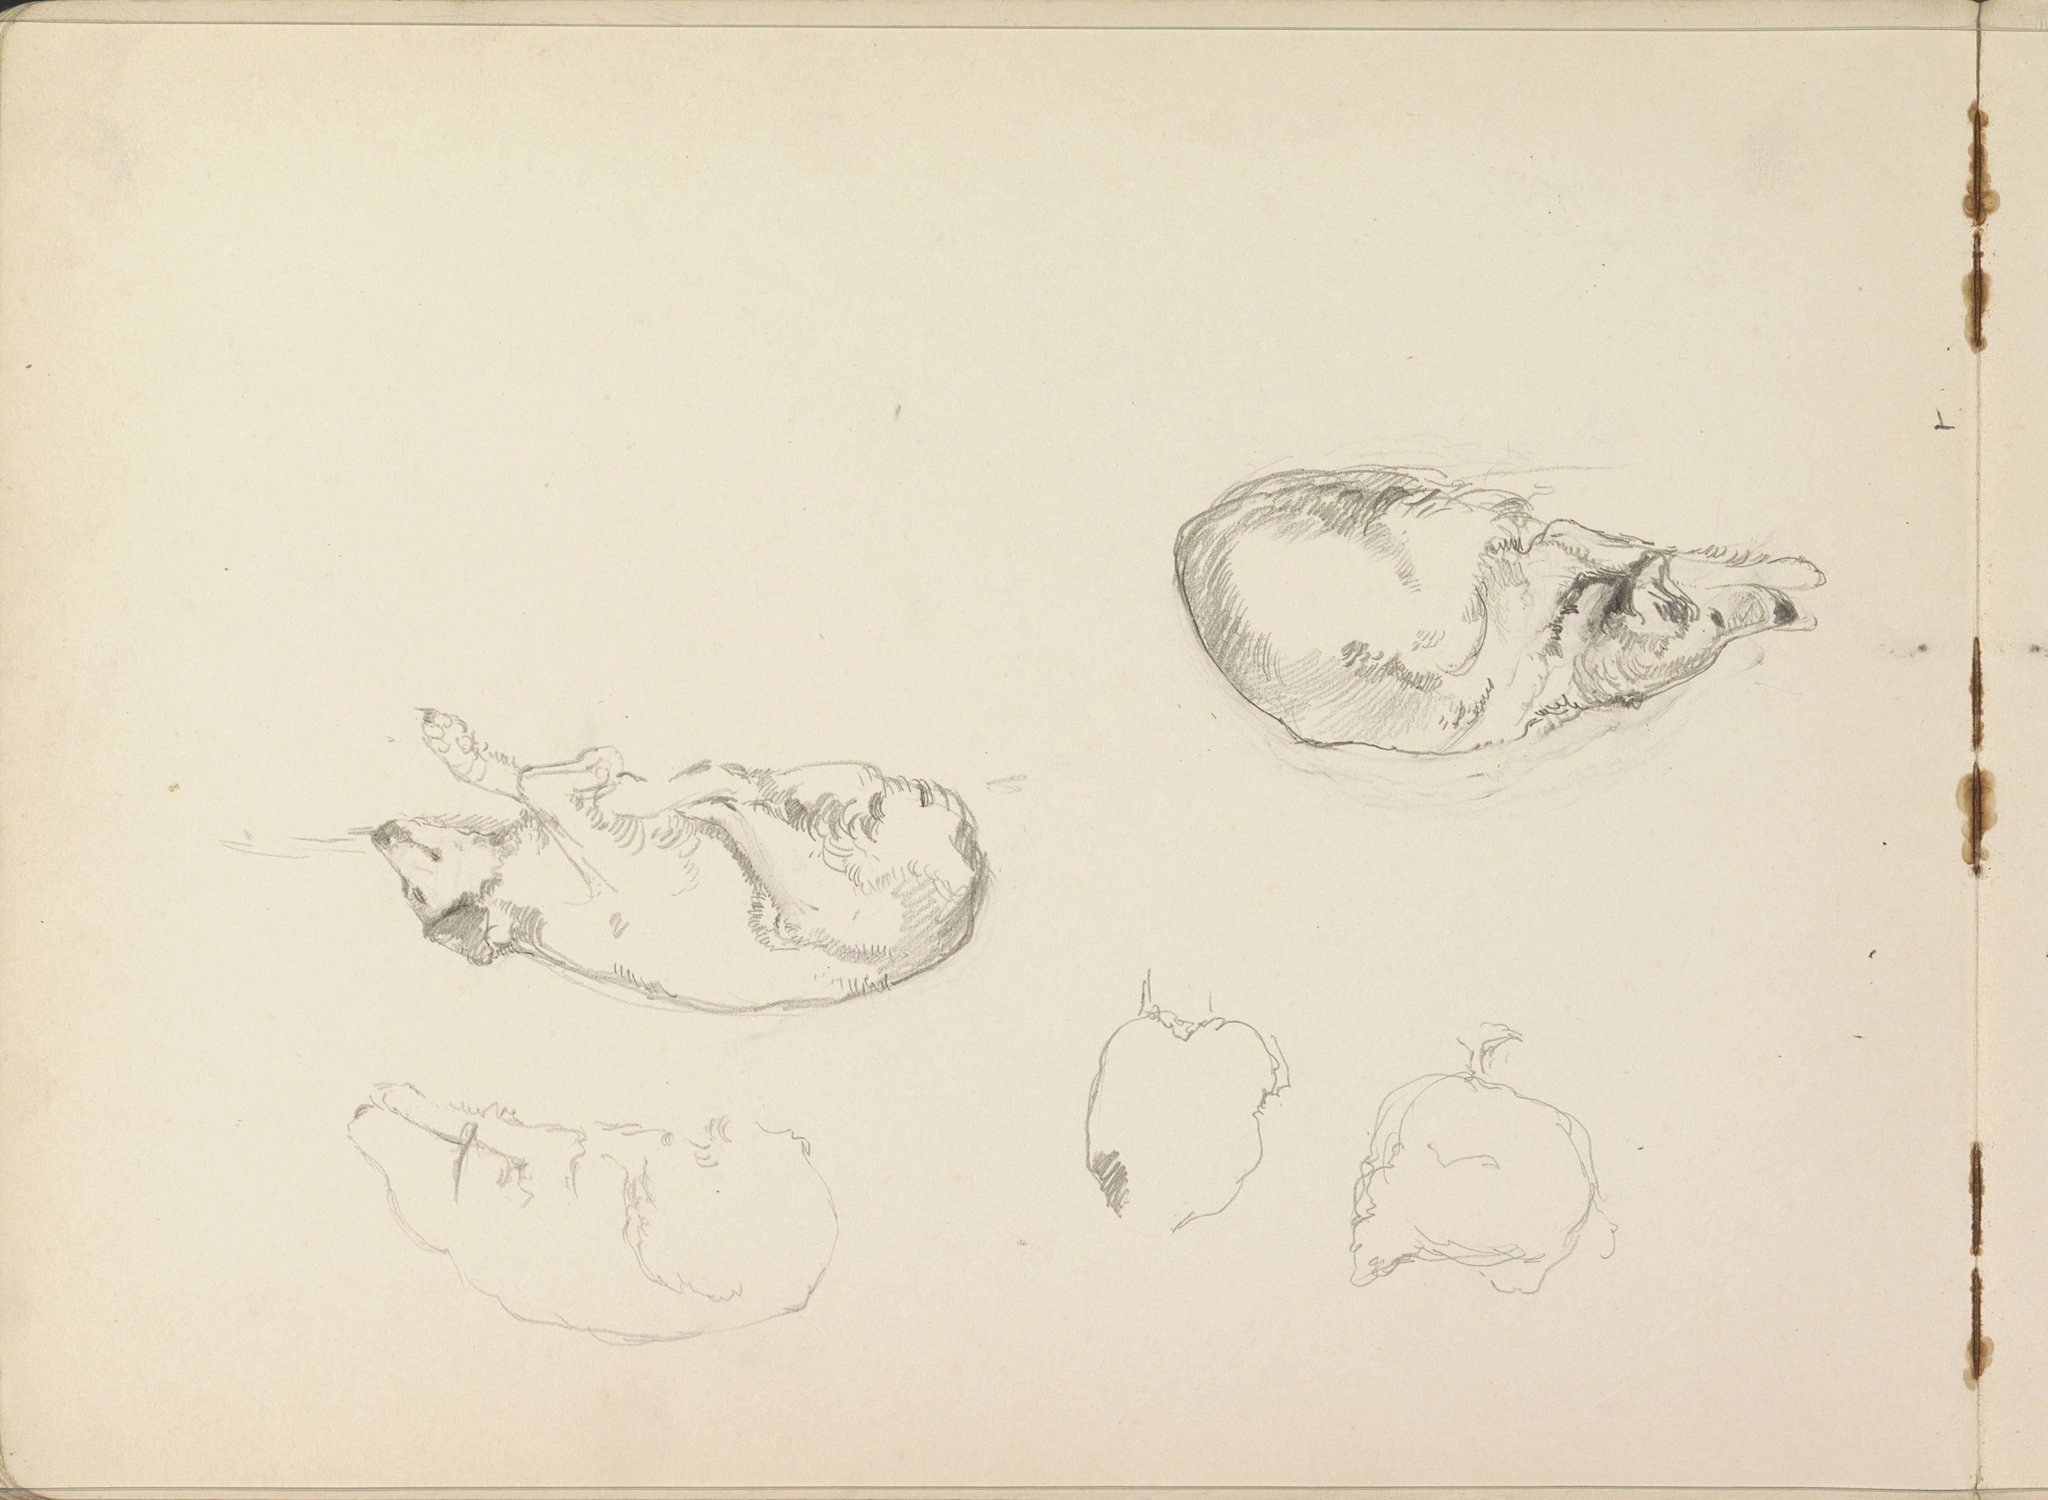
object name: sketchbook leaf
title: Kip en liggende honden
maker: cornelis vreedenburgh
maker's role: draughtsman, print maker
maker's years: 1880-1946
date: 1890-1946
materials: paper, pencil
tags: fowl (cock, hen, chicken, etc.), dog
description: Blad 17 verso uit een schetsboek met 23 bladen.